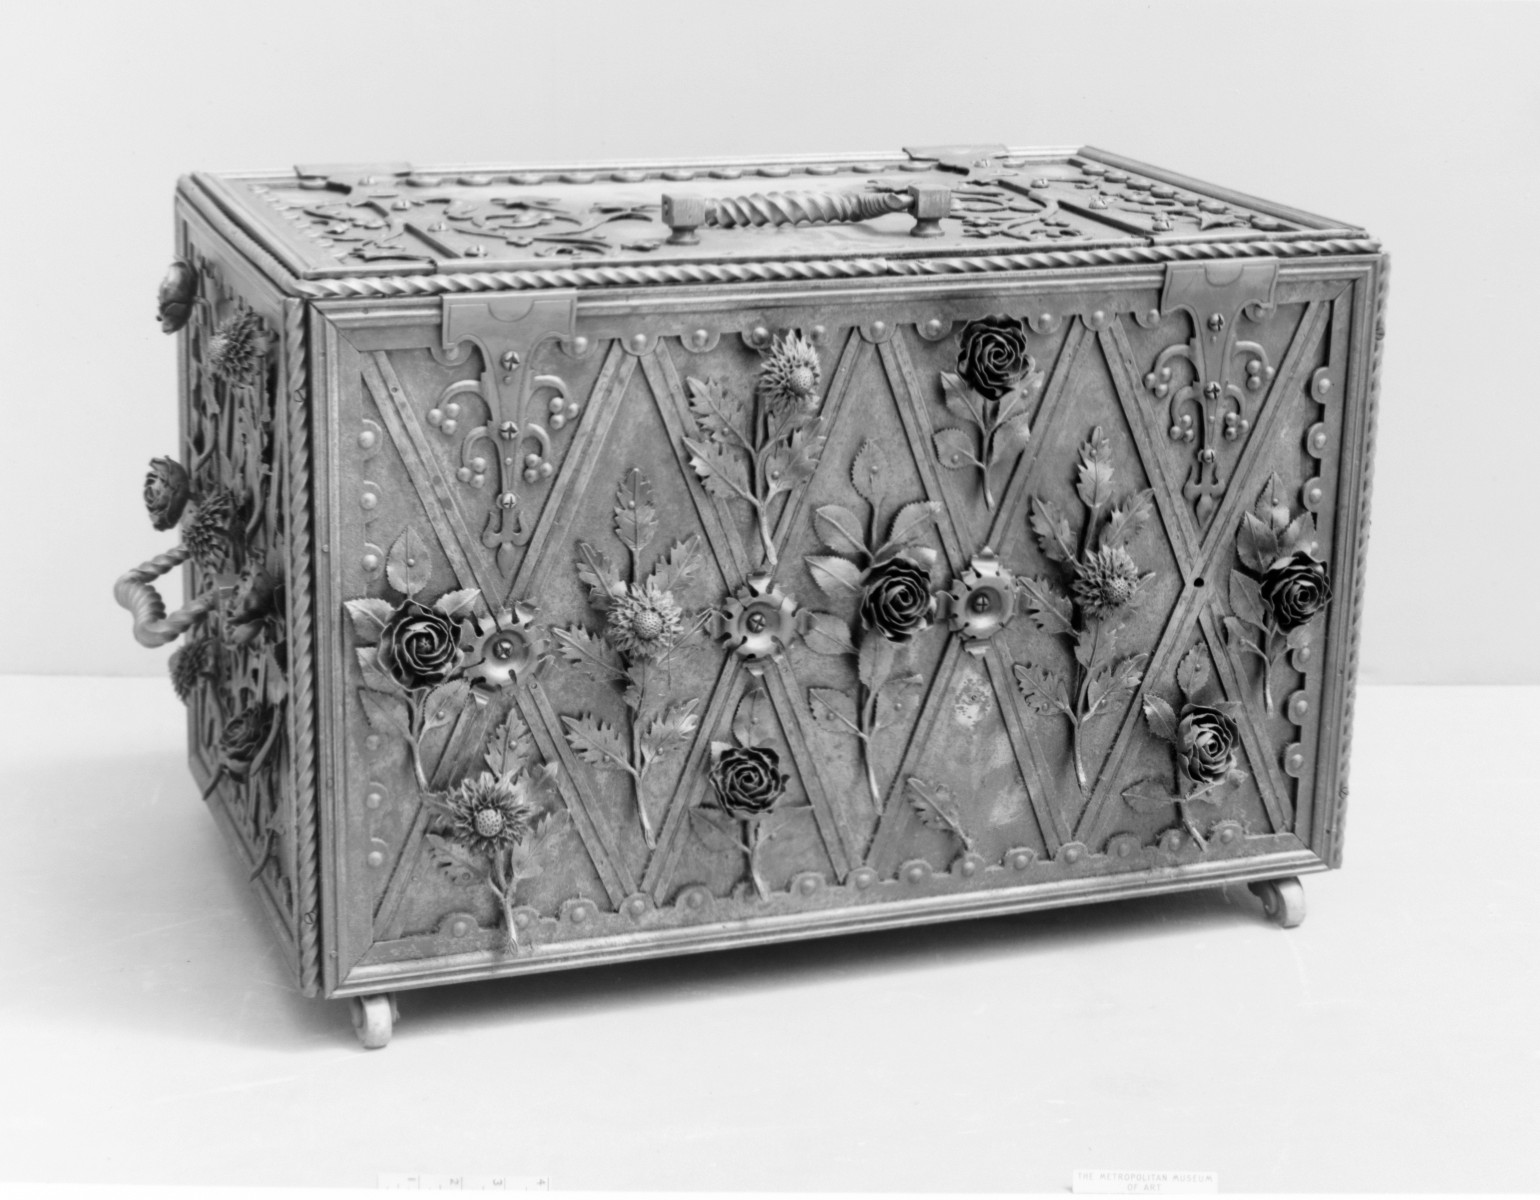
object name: chest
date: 1801-1900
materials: iron